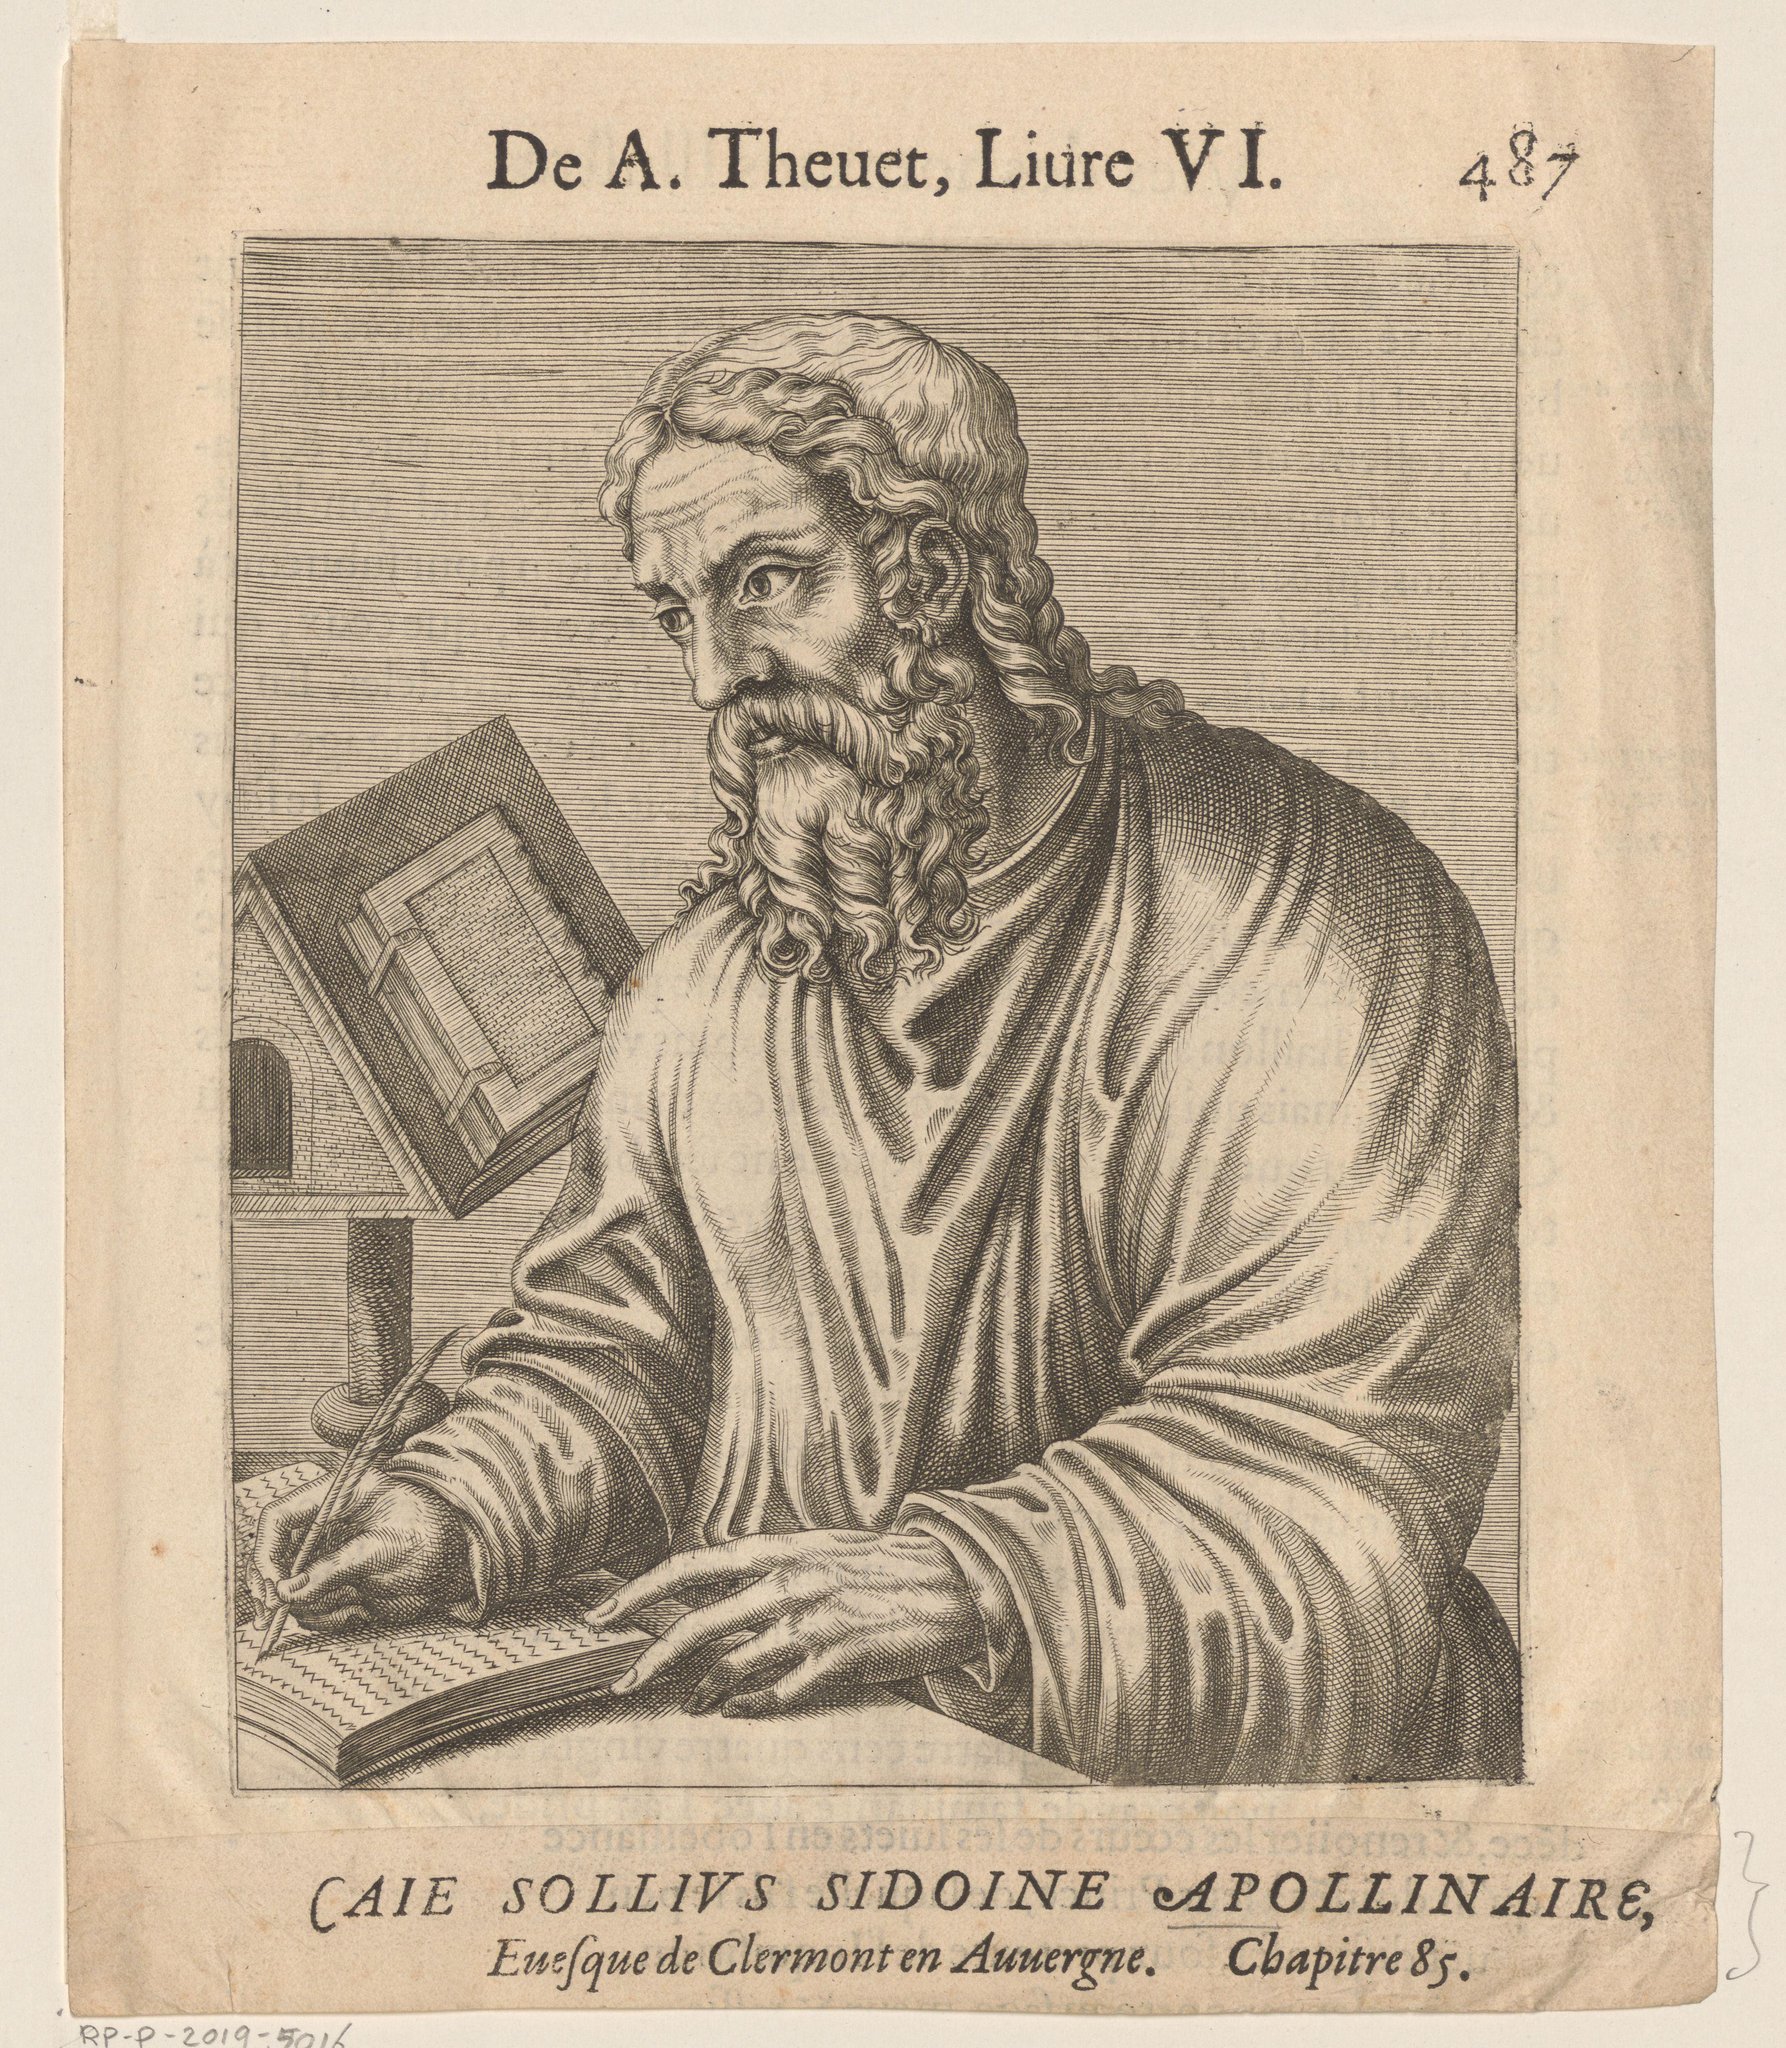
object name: book illustration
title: Portret van Sidonius Apollinaris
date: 1584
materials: paper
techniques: engraving, letterpress printing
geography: paris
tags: lyon, historical persons, book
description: Prent uit: Thevet, André. Les vrais pourtraits et vies des hommes illustres grecz, latins et payens (...). Parijs: weduwe Jacques Kerver en Guillaume Chaudière, 1584, dl. 2, f. 487.